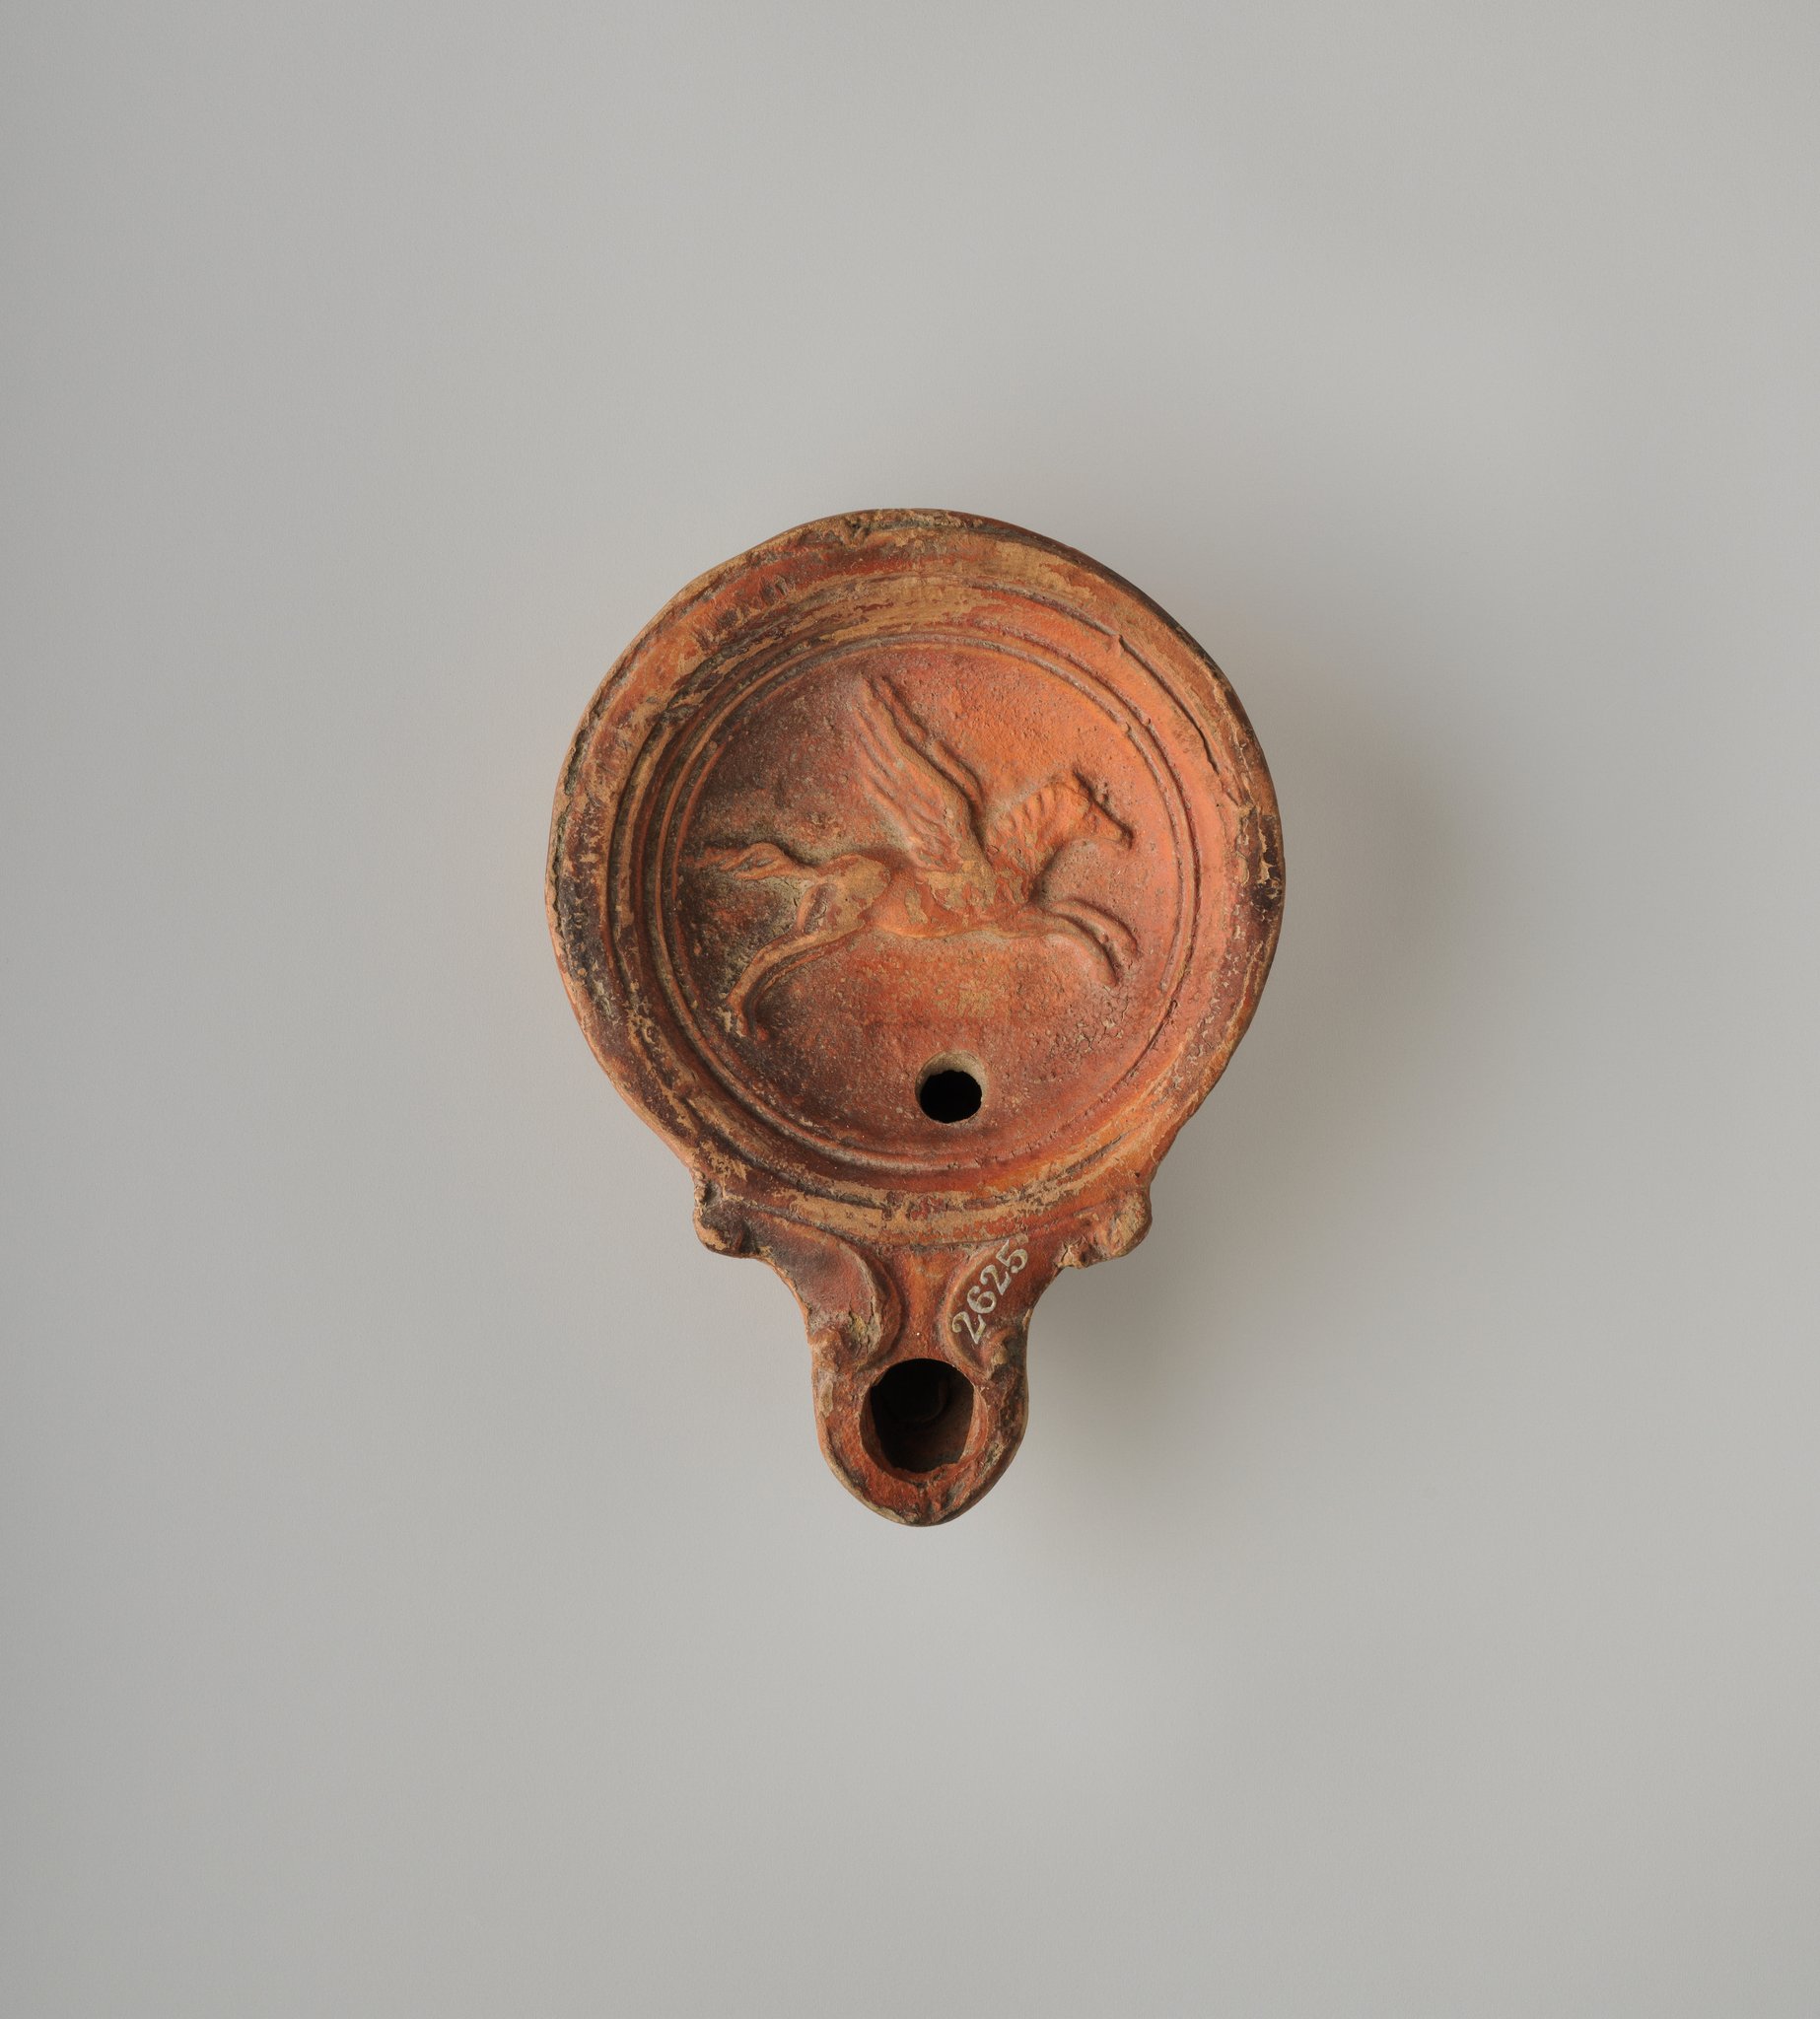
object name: lamp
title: Terracotta oil lamp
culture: roman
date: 1-100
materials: terracotta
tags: pegasus